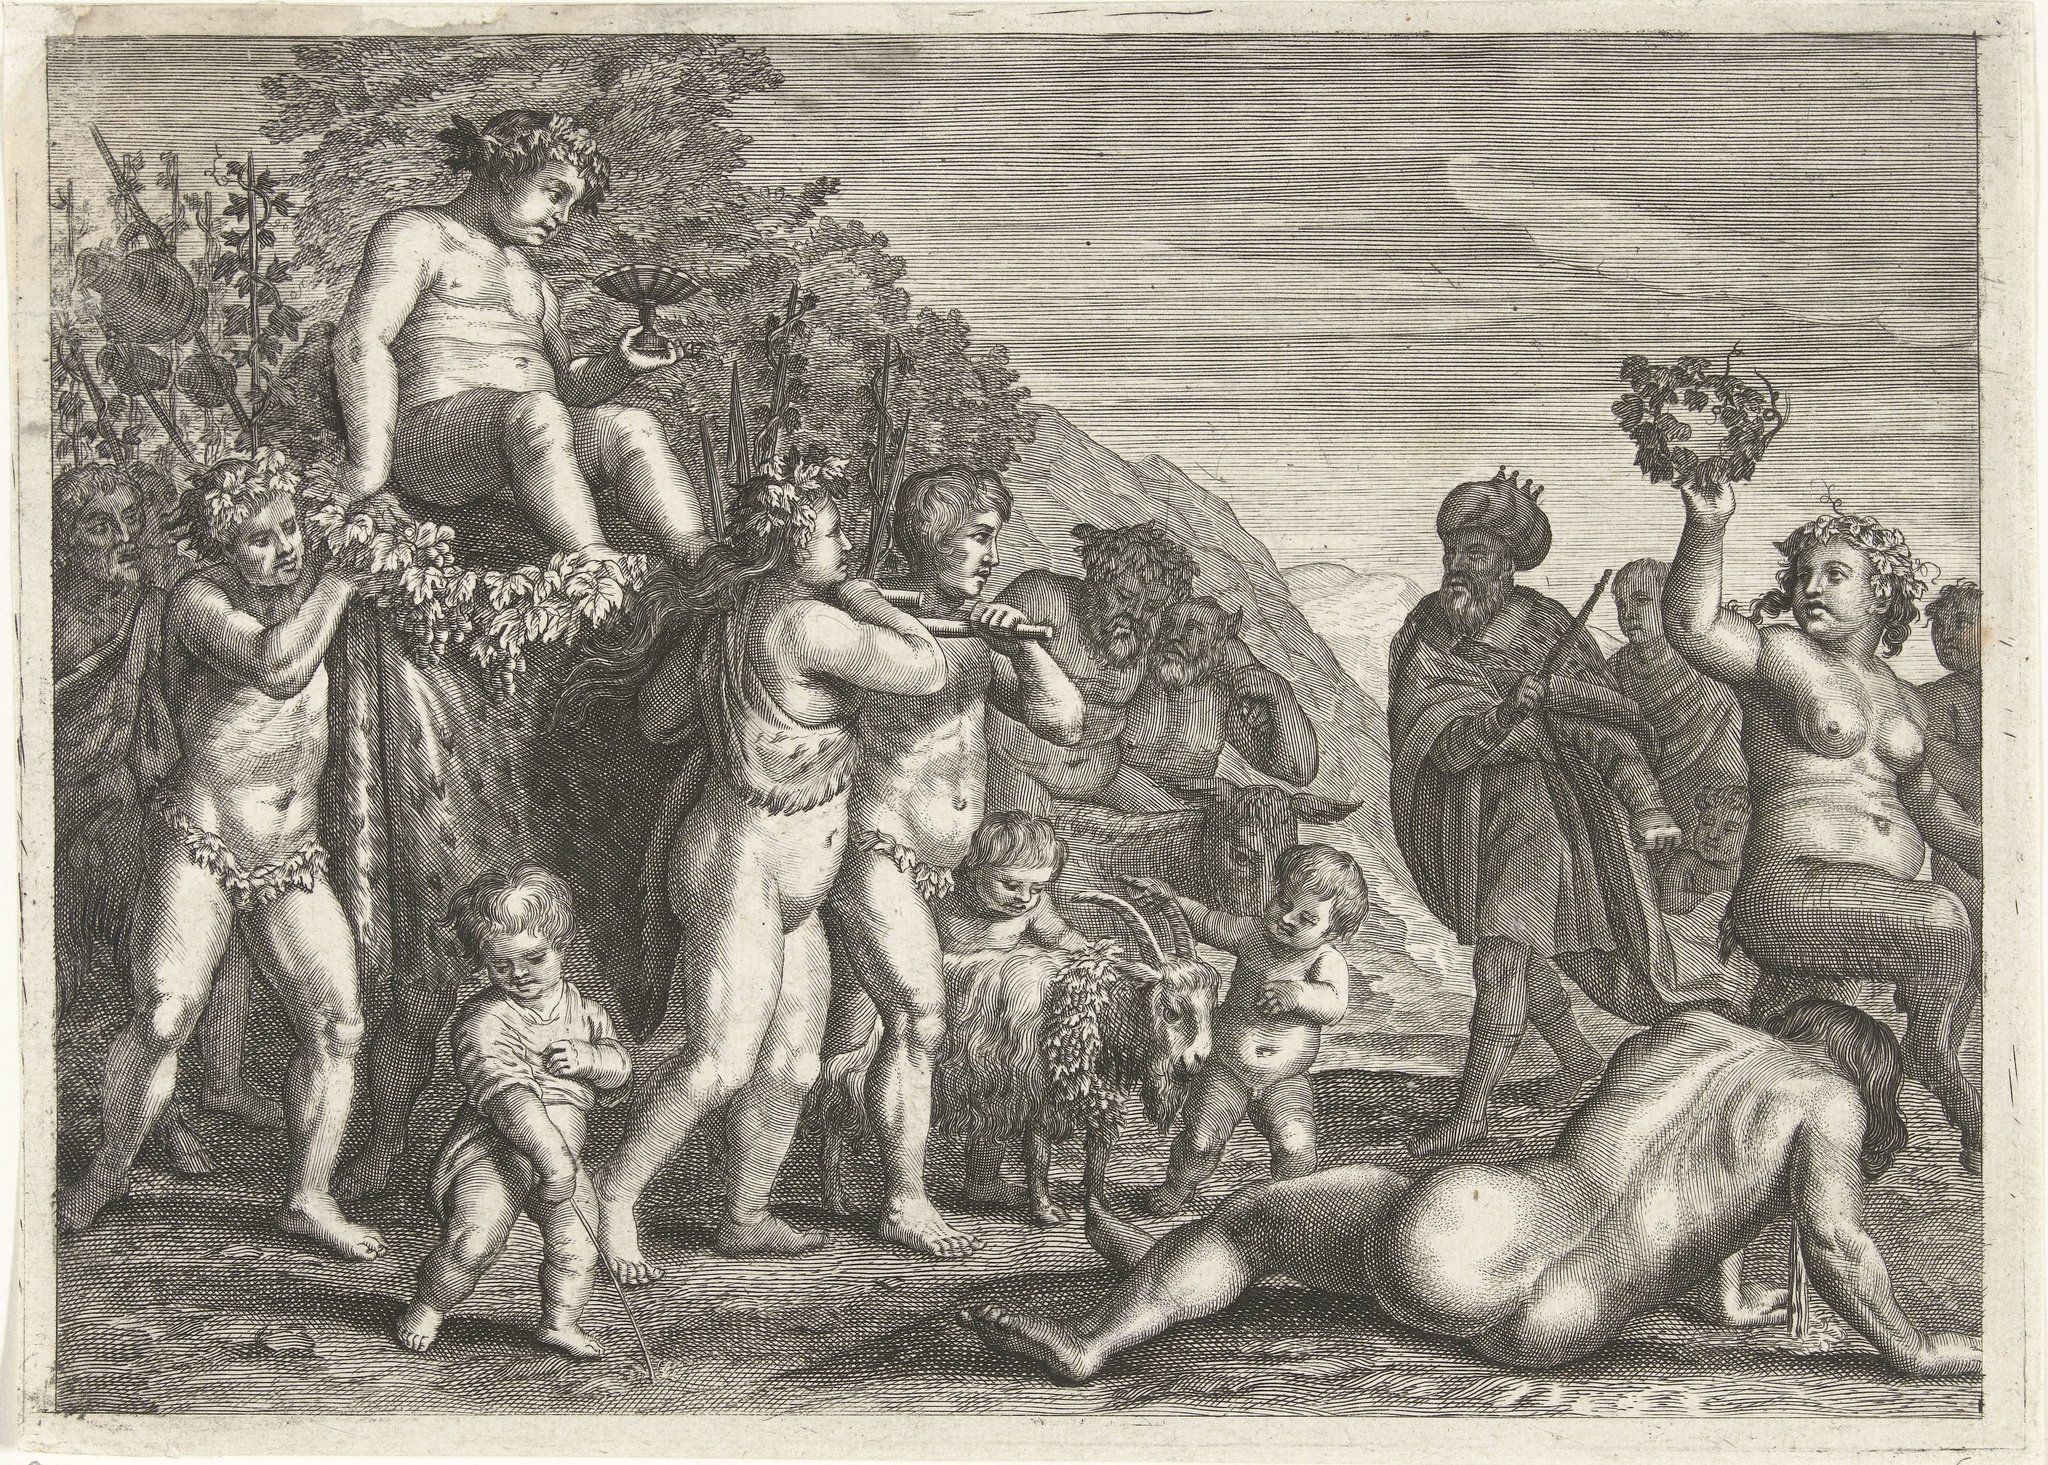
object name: print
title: Triomf van Bacchus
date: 1677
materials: paper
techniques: engraving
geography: antwerp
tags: bacchanal: bacchus with his wine-flushed train (thiasos), pentheus withstands the cult of bacchus in thebes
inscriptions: collector's mark: Lugt 2228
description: De prent beeldt een fabel uit de Metamorfosen (3:8). Een stoet putti, bacchanten en saters dragen de wijngod Bacchus op een draagstoel. De dronken Silenus is ook aanwezig, rijdend op een ezel en gesteund door een sater. Op de voorgrond van de prent is een van de maenaden aan het braken. Op de achtergrond van de prent koning Pentheus van Thebe, de neef van Bacchus, die zijn onderdanen verbiedt Bacchus te aanbidden.